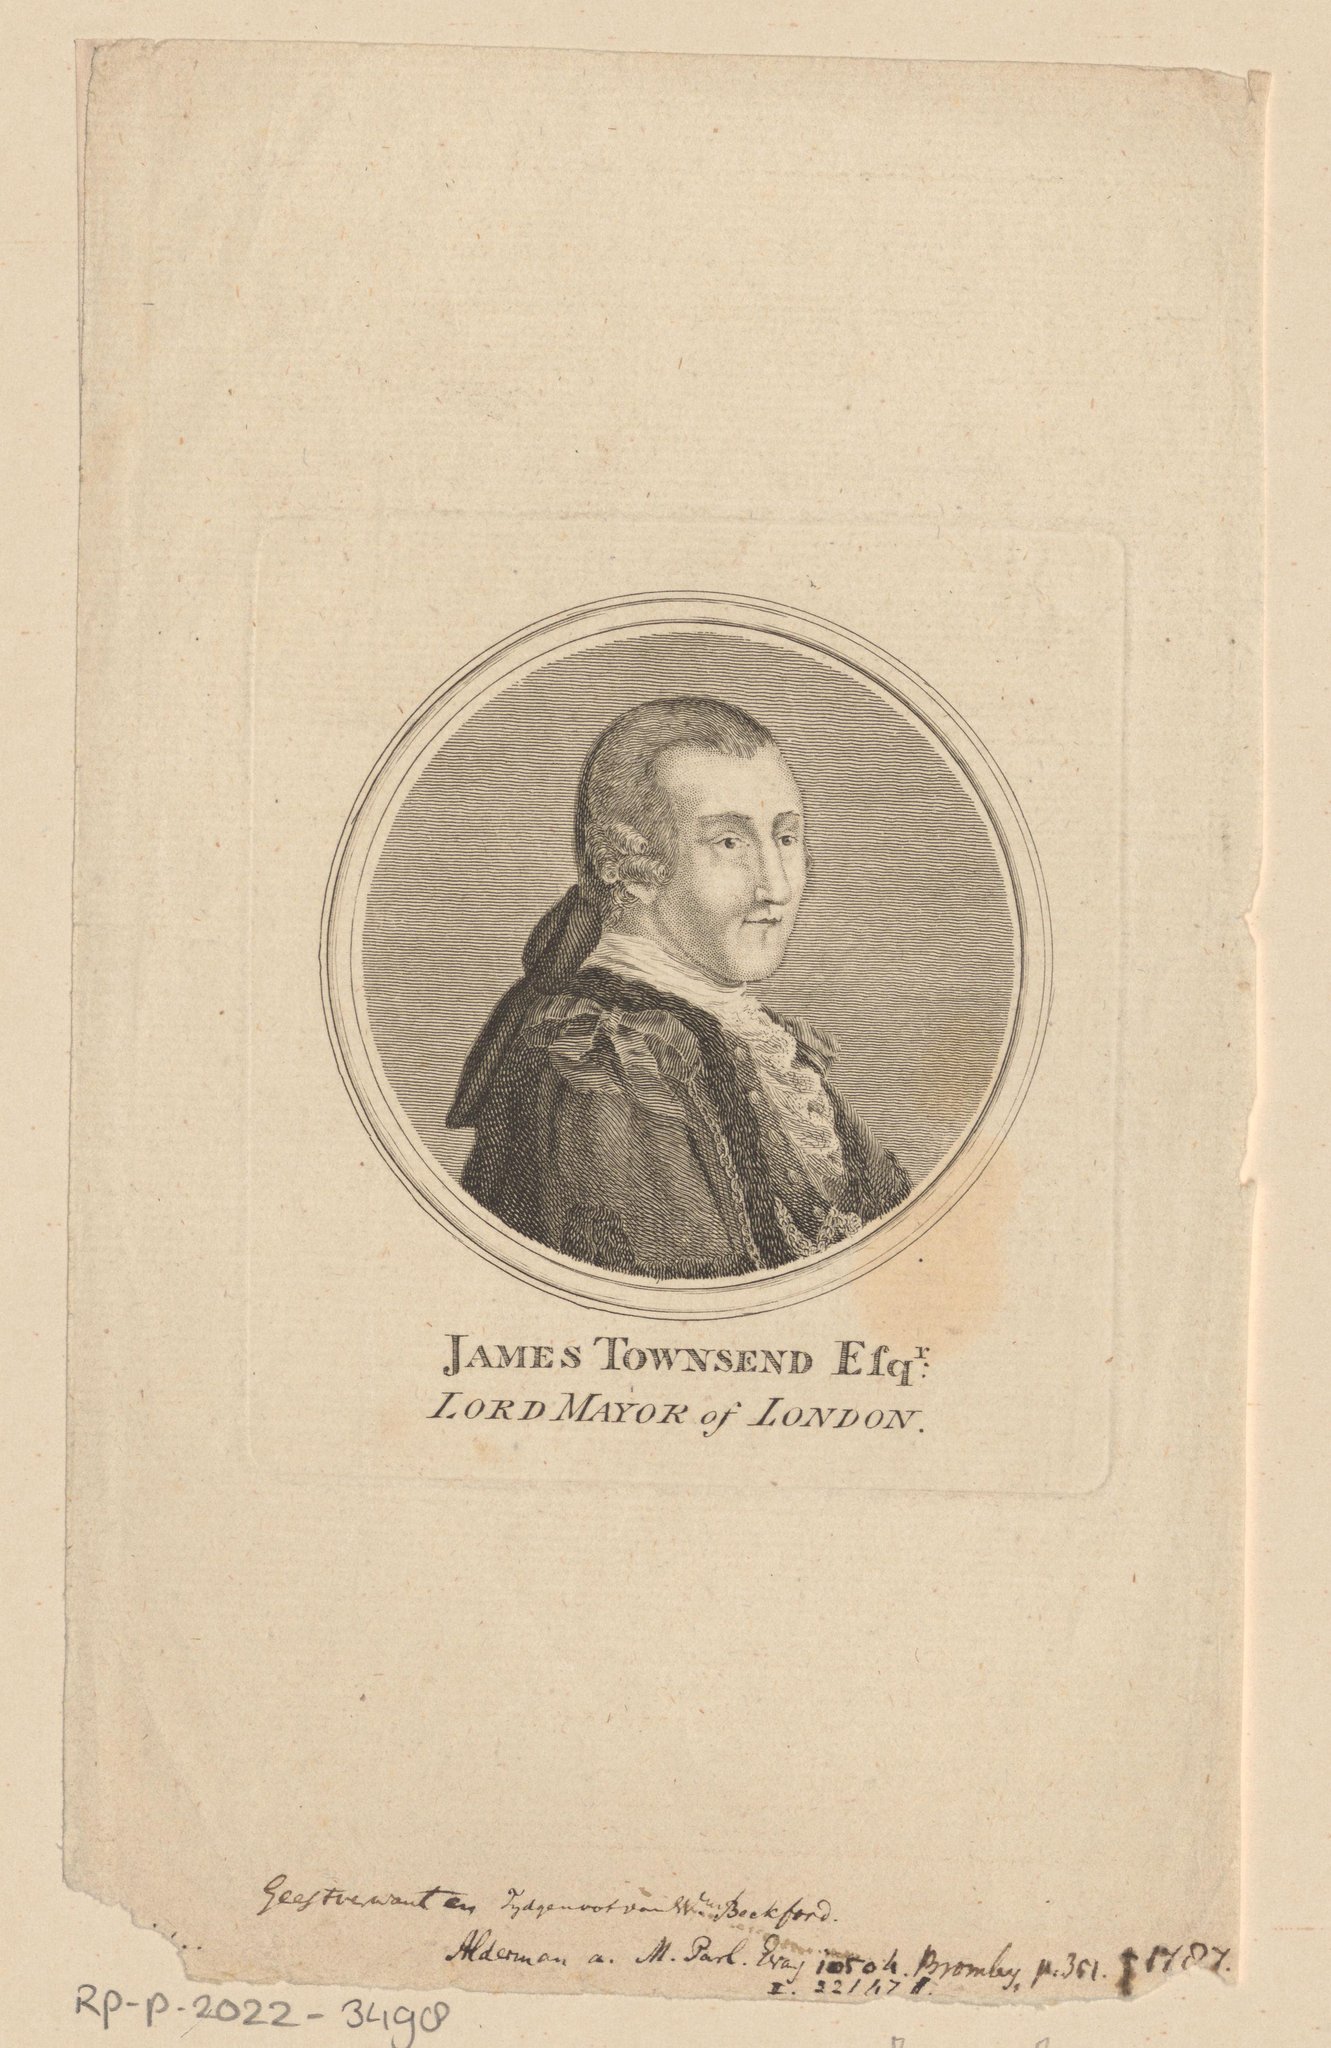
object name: print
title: Portret van James Townsend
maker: Anonymous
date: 1772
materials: paper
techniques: etching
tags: politician, mayor, historical persons, politician, e.g. party leader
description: Prent waarschijnlijk uit: The London Magazine (1772), nr 41.